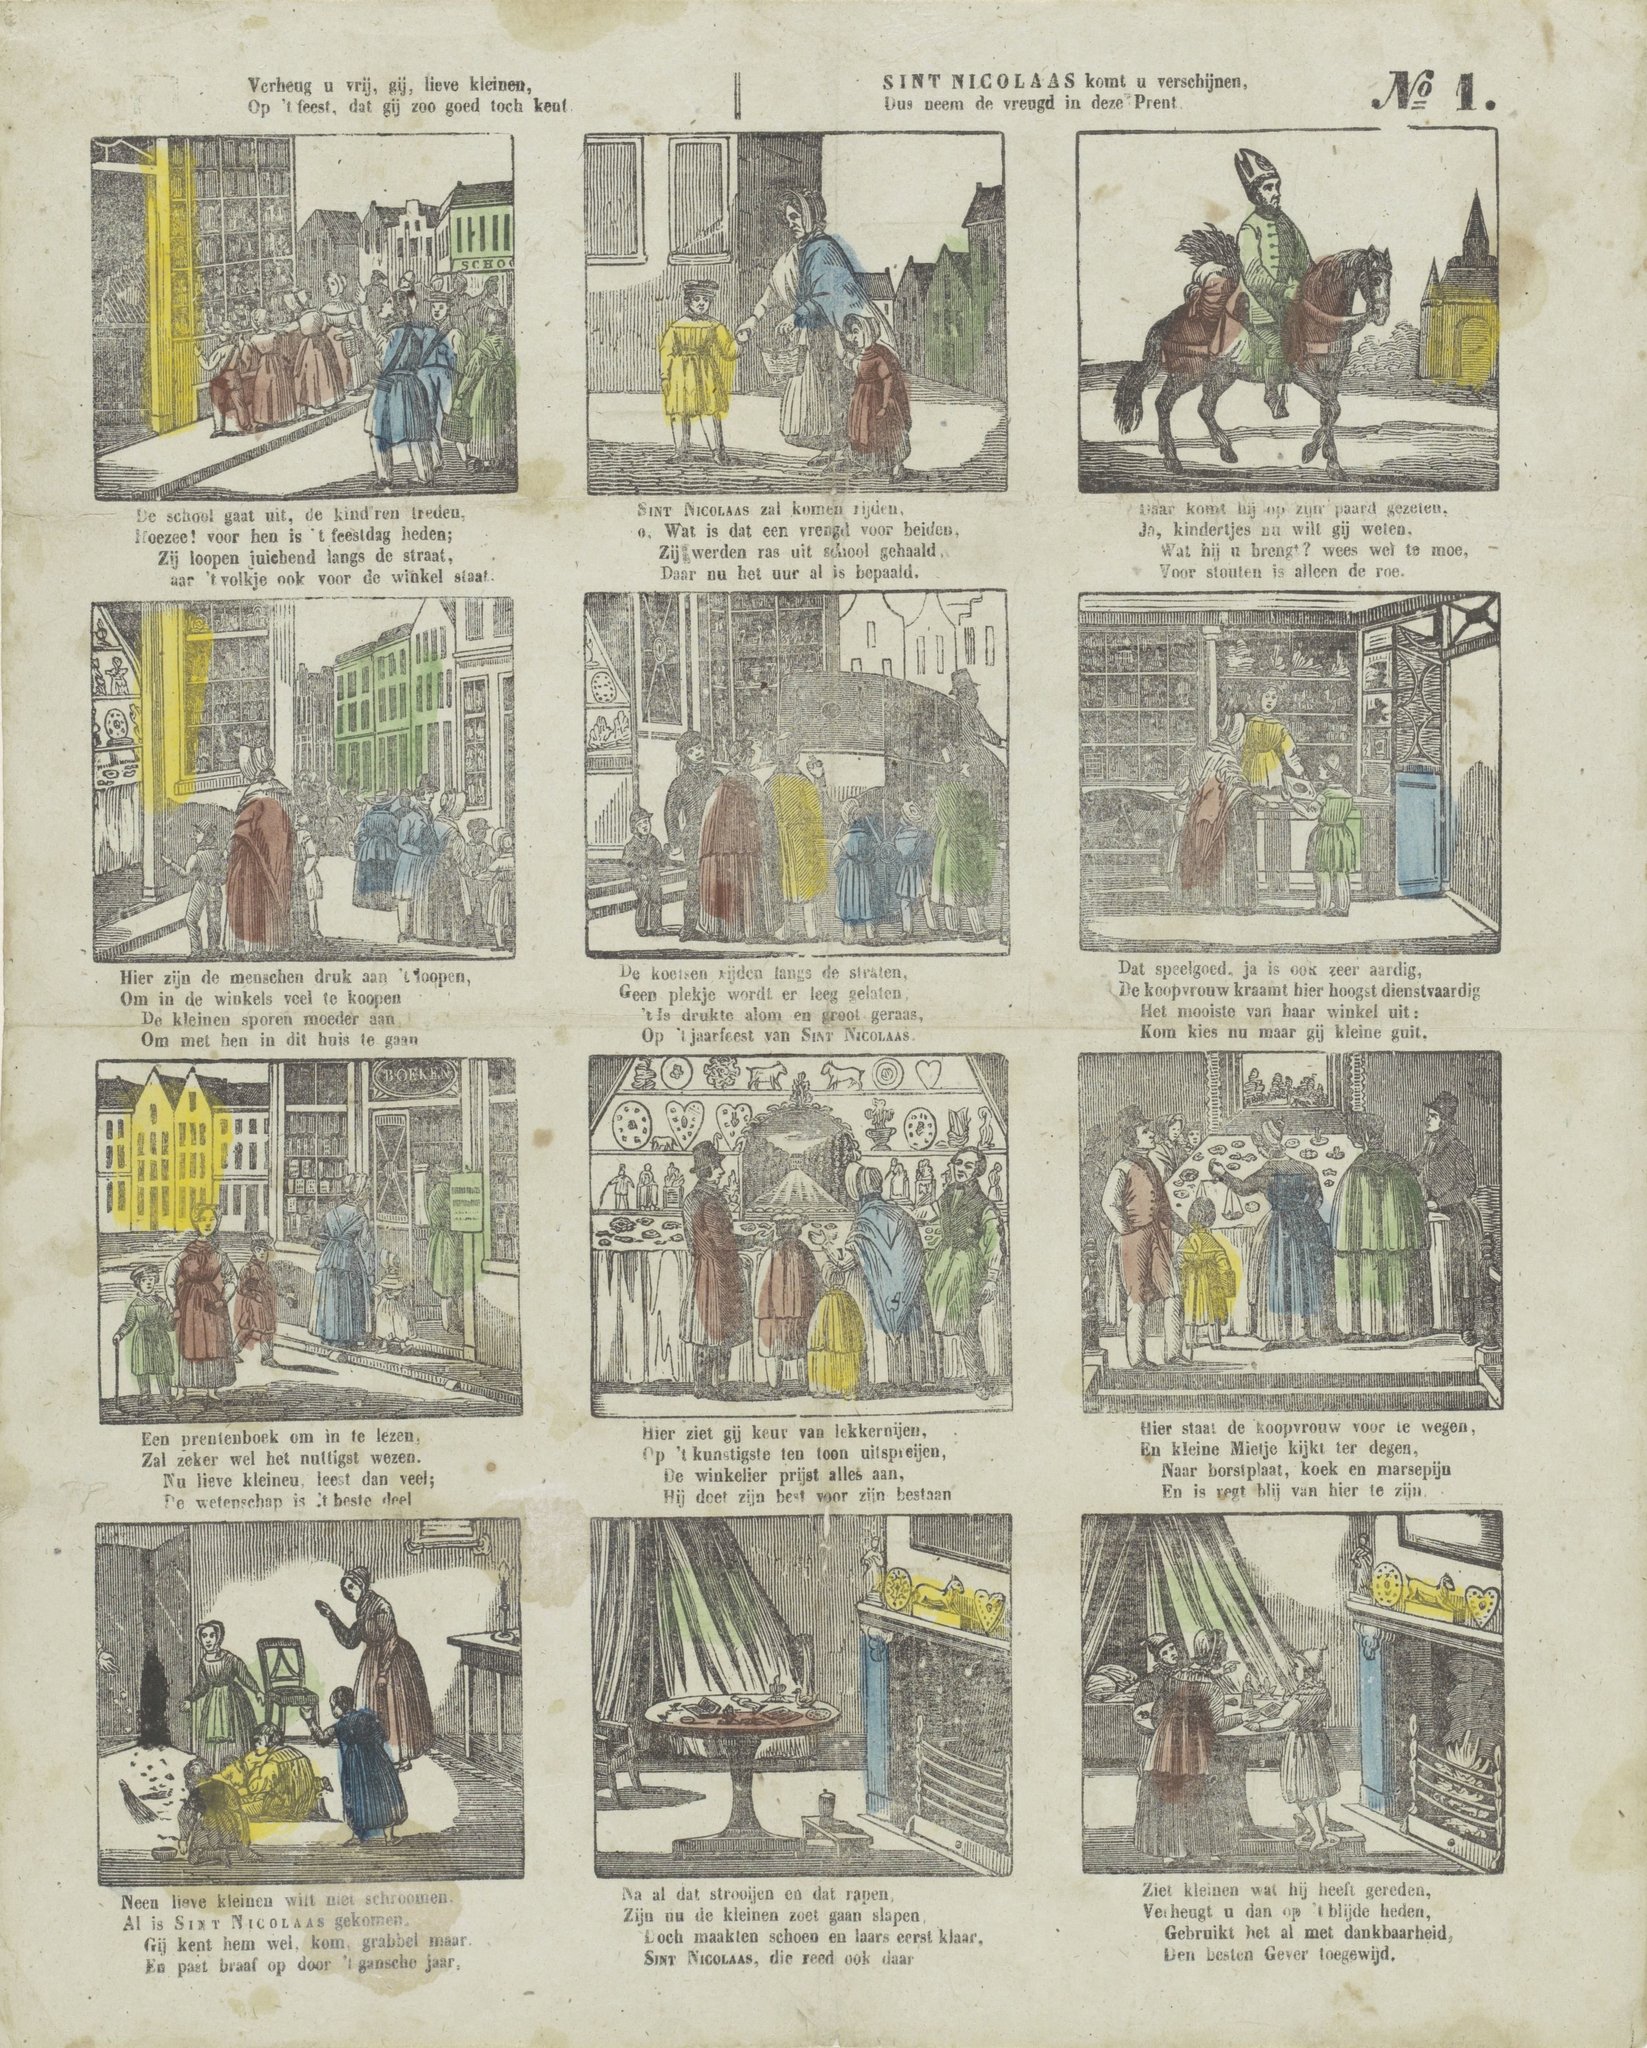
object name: popular print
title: Verheugt u vrij, gij, lieve kleinen, / Op 't feest, dat gij zoo goed toch kent. / Sint Nicolaas komt u verschijnen, / Maar neen, de vreugd in deze prent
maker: Anonymous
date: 1850-1870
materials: paper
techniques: colour, letterpress printing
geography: netherlands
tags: the bishop nicholas of myra (or bari); possible attributes: anchor, boat, three golden balls (on a book), three purses, three children in a tub, three maidens, festivities on st. nicholas (eve) (december 5)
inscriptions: collector's mark: Lugt 2760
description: Blad met 12 voorstellingen over Sint Nicolaas en het Sinterklaasfeest. Onder elke afbeelding een vierregelig vers. Rechtsboven genummerd: No 1.